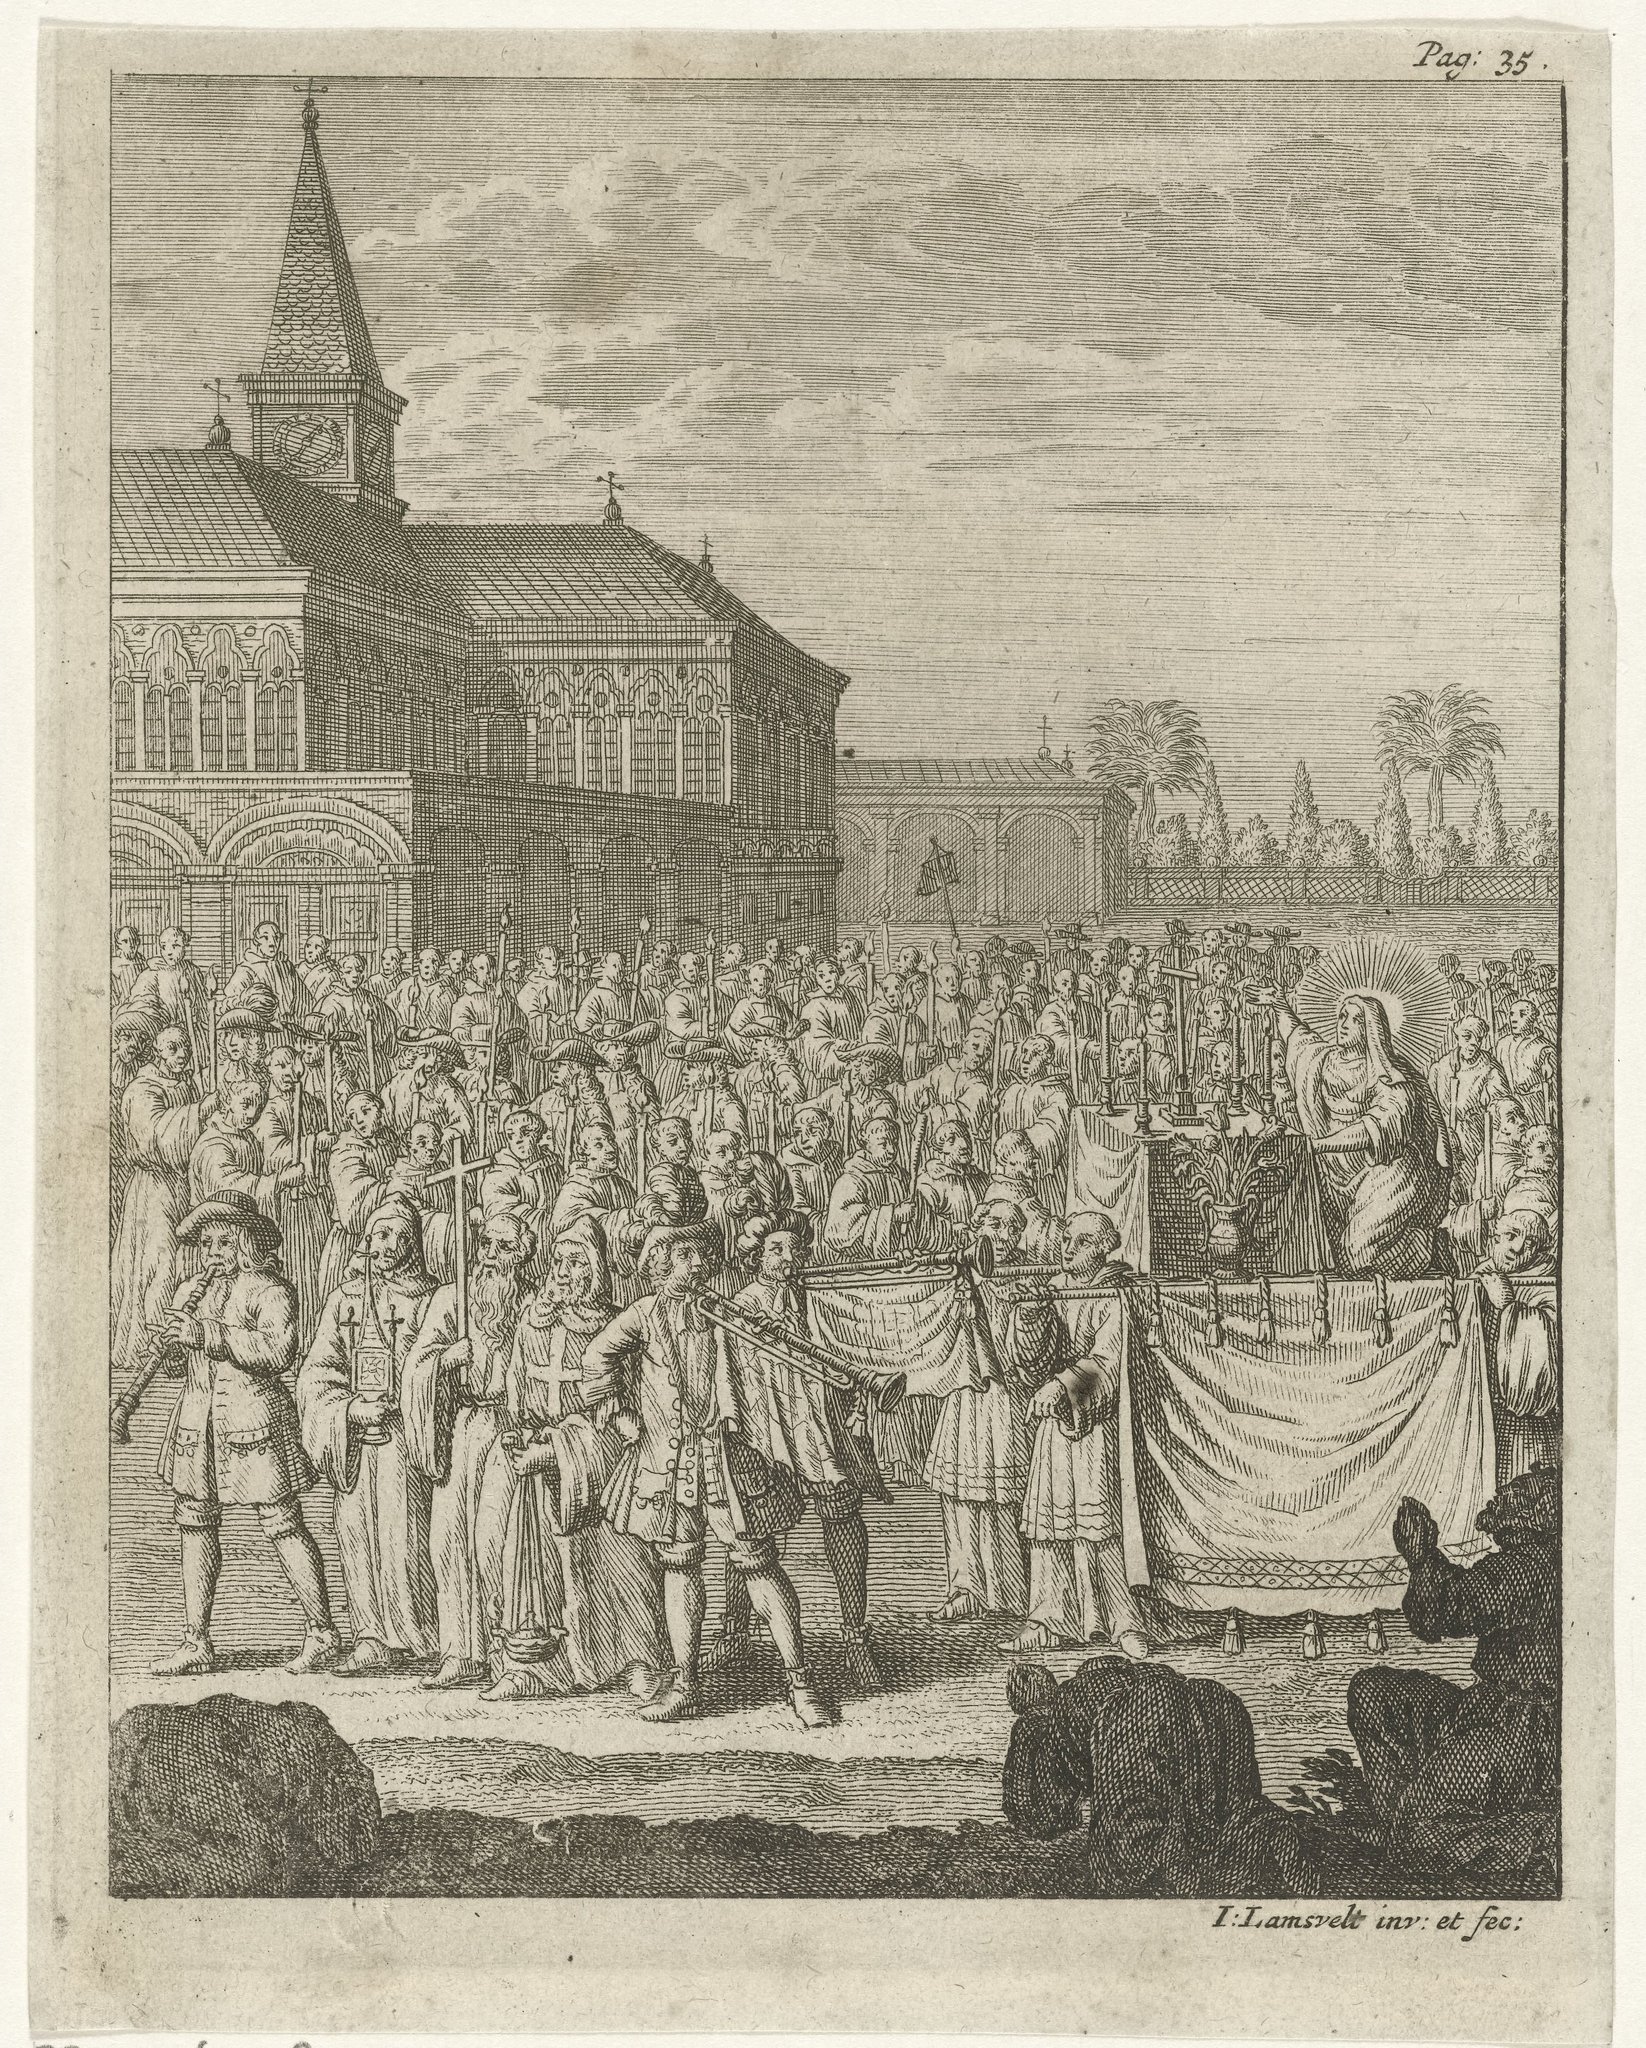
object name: print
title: Processie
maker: jan lamsvelt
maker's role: print maker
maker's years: 1674-1743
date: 1684-1743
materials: paper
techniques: etching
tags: procession ~ christian religion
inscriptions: collector's mark: Lugt 2760, collector's mark: Lugt 2228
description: Processie met geestelijken en trompet blazende figuren. Op de draagbaar ontsteekt een gesluierde vrouw, wier hoofd is omringd met een aureool, de kaarsen. Prent rechtsboven gemerkt: Pag: 35